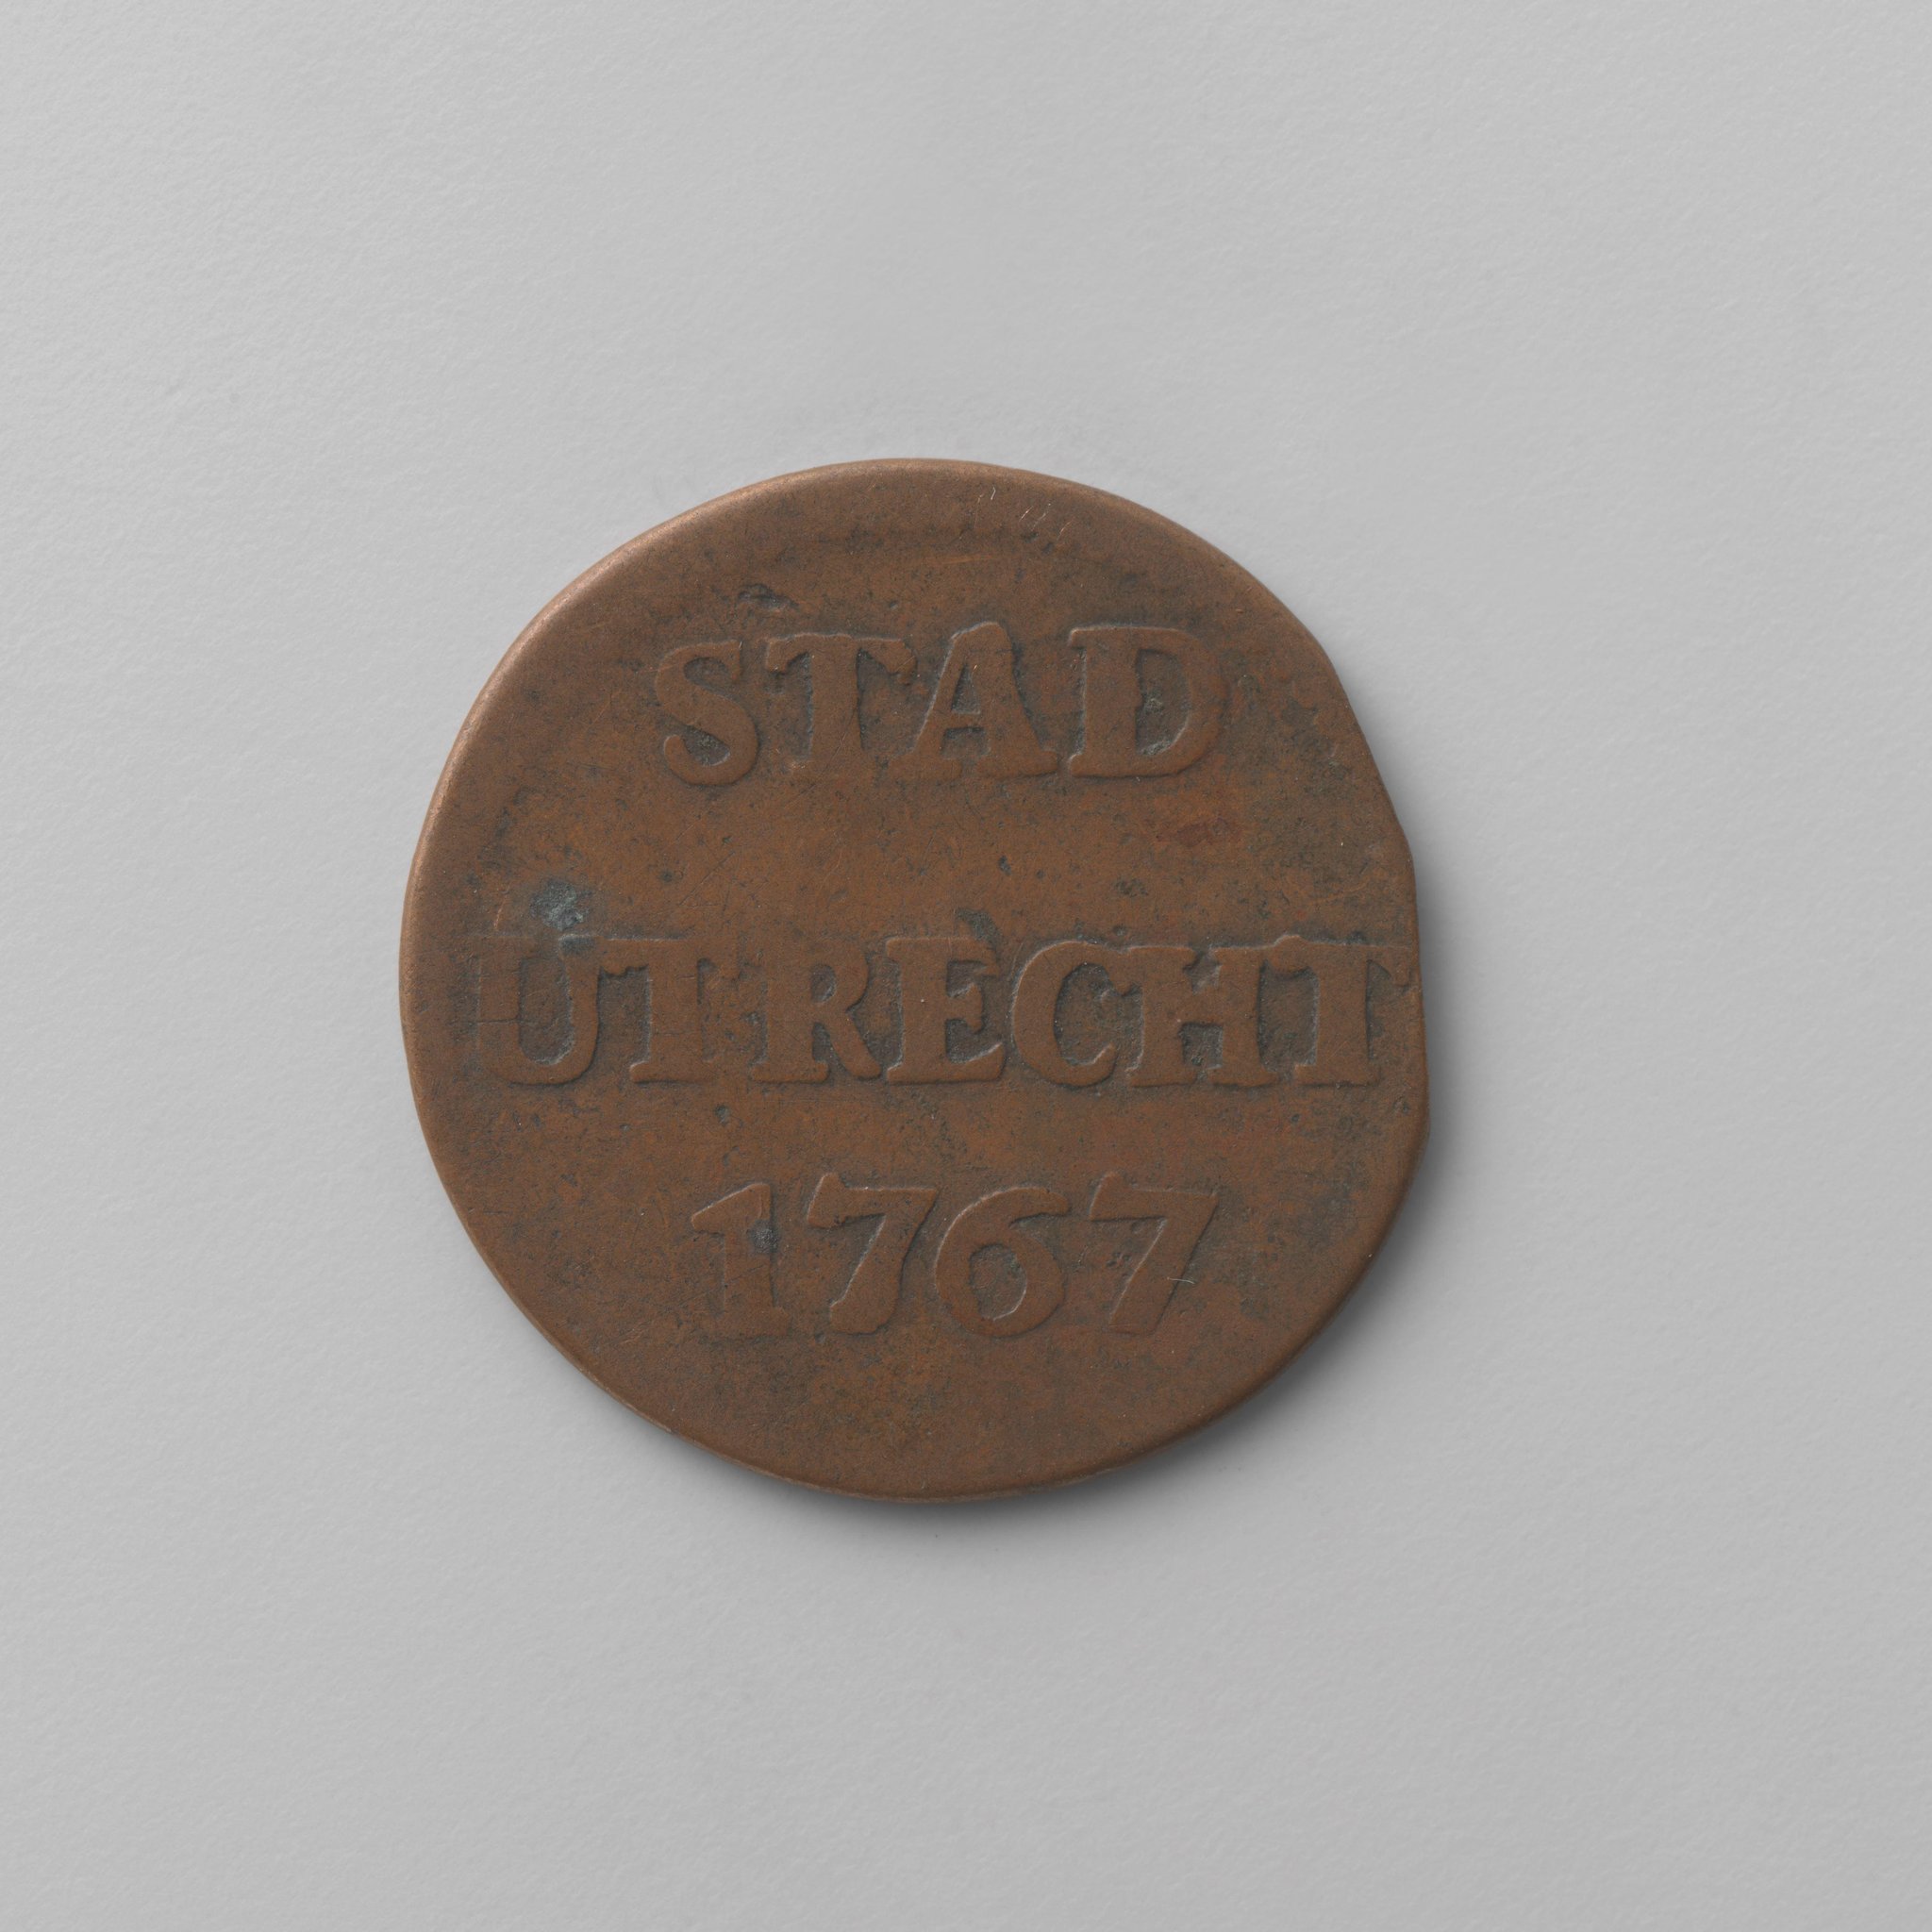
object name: coin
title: Duit van de stad Utrecht, 1767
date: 1767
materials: copper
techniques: striking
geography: utrecht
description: Koperen munt. Voorzijde: gekroond stedelijk wapenschild, gehouden door twee leeuwen met in afsnede dikke lijn, waaronder een versierde accolade met een grote schelp. Keerzijde: opschrift in twee regels, waaronder jaartal. Jaartal met Arabische 1.